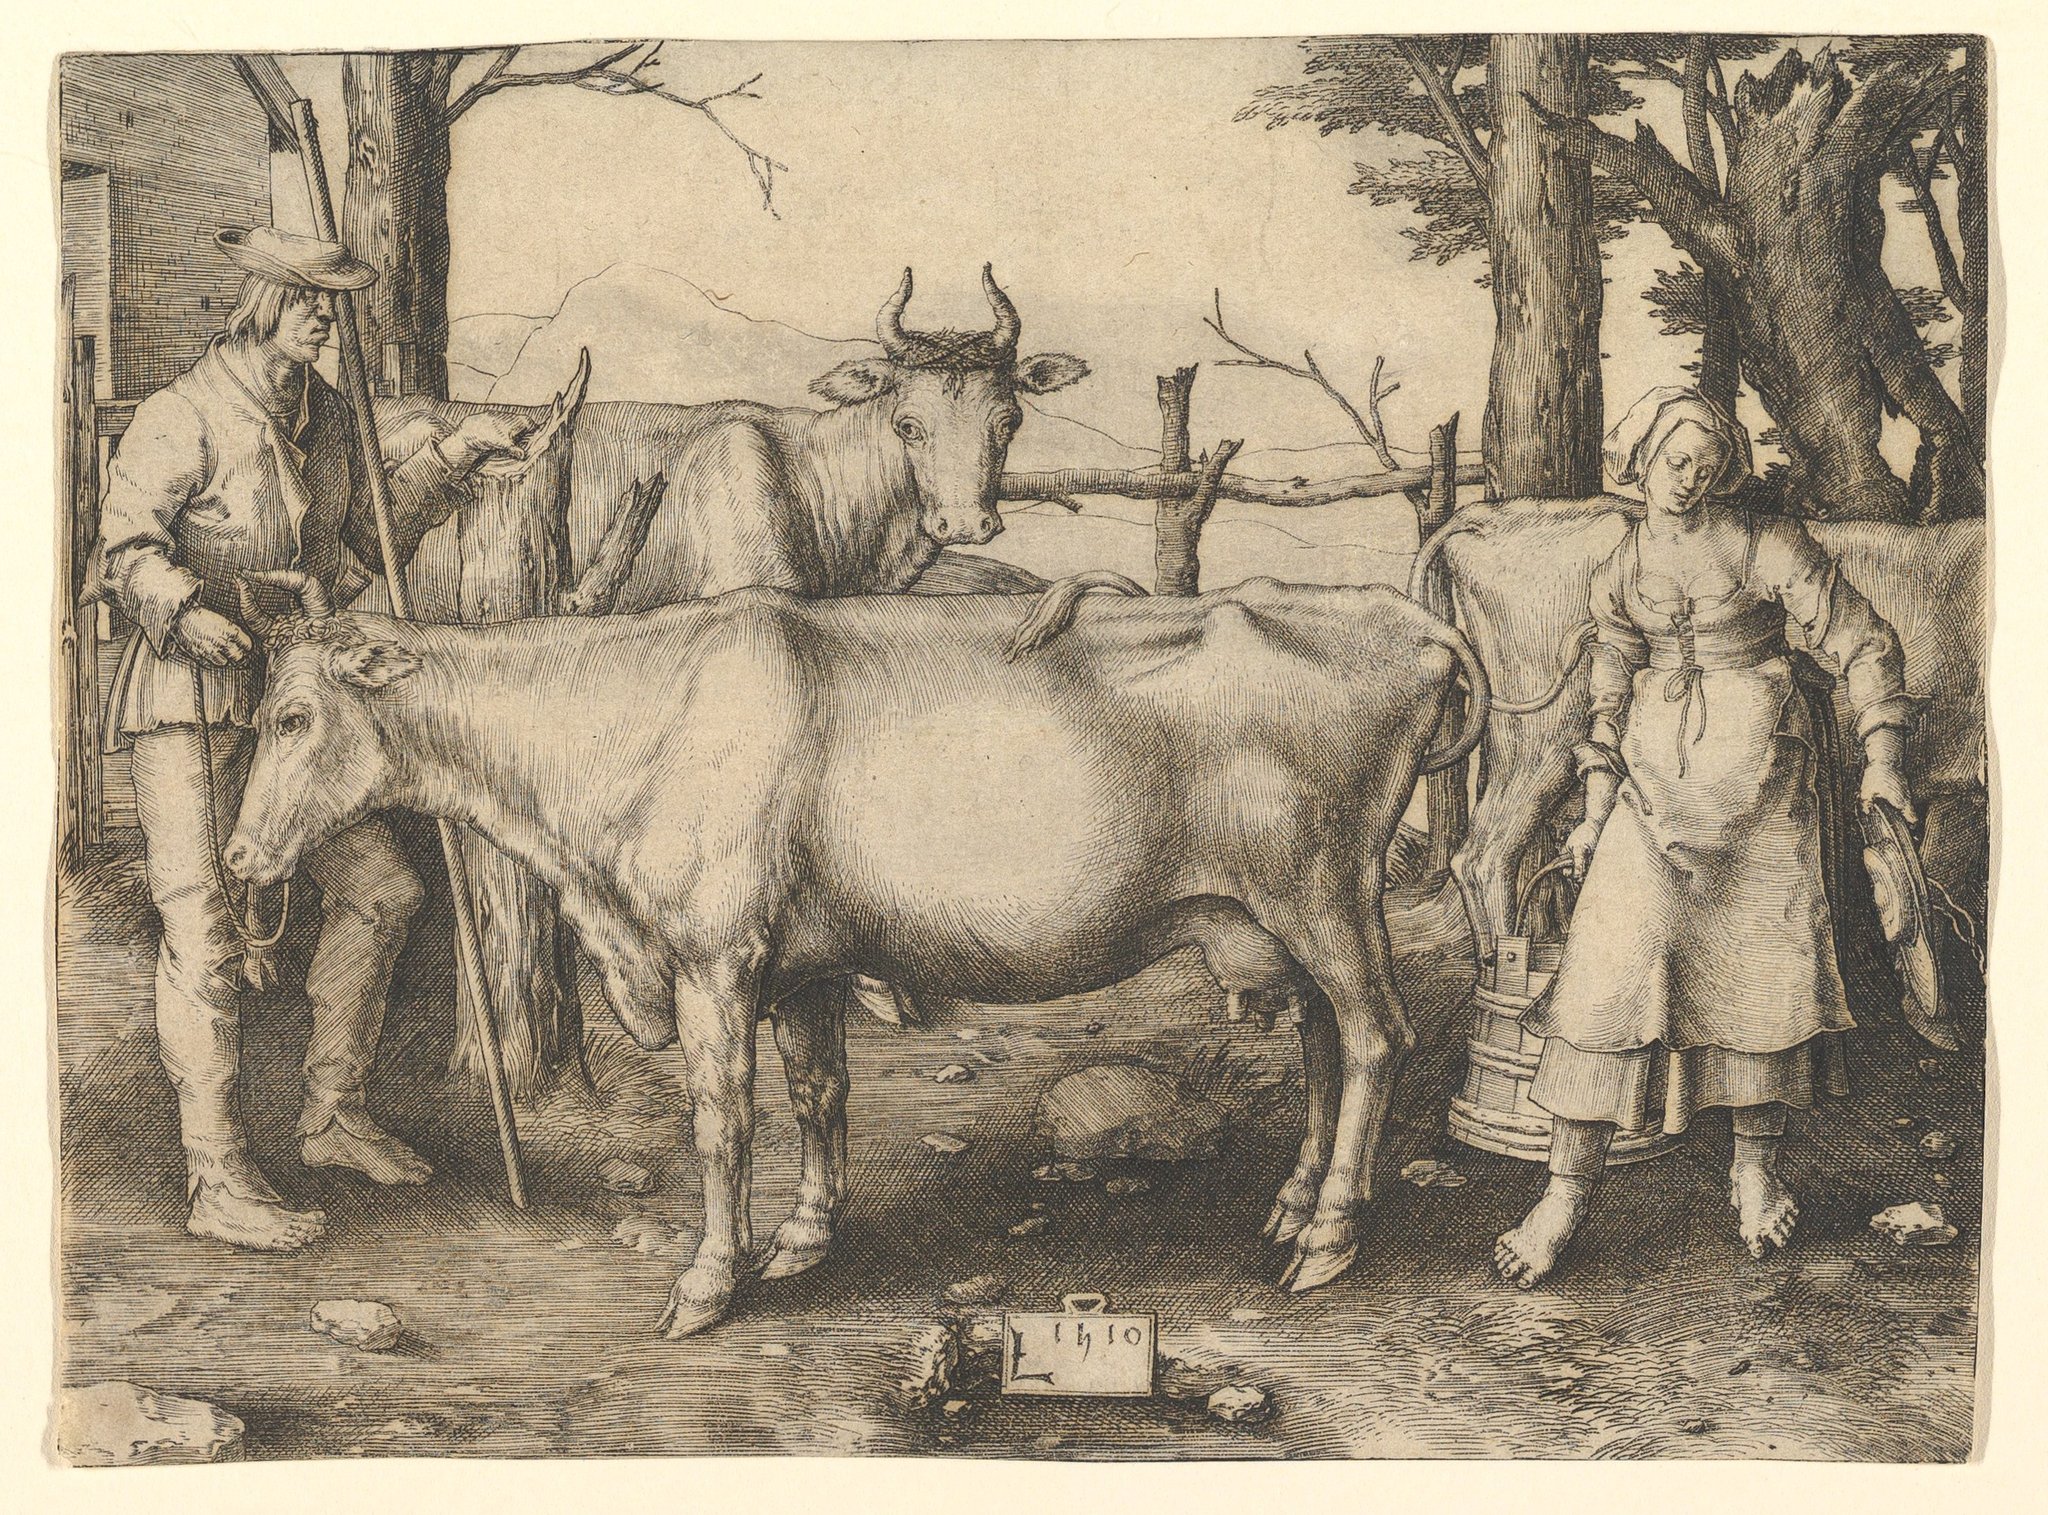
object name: print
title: The Milkmaid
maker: lucas van leyden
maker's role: artist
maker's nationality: netherlandish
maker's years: 1494-1533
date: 1510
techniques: engraving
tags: men,women,cows